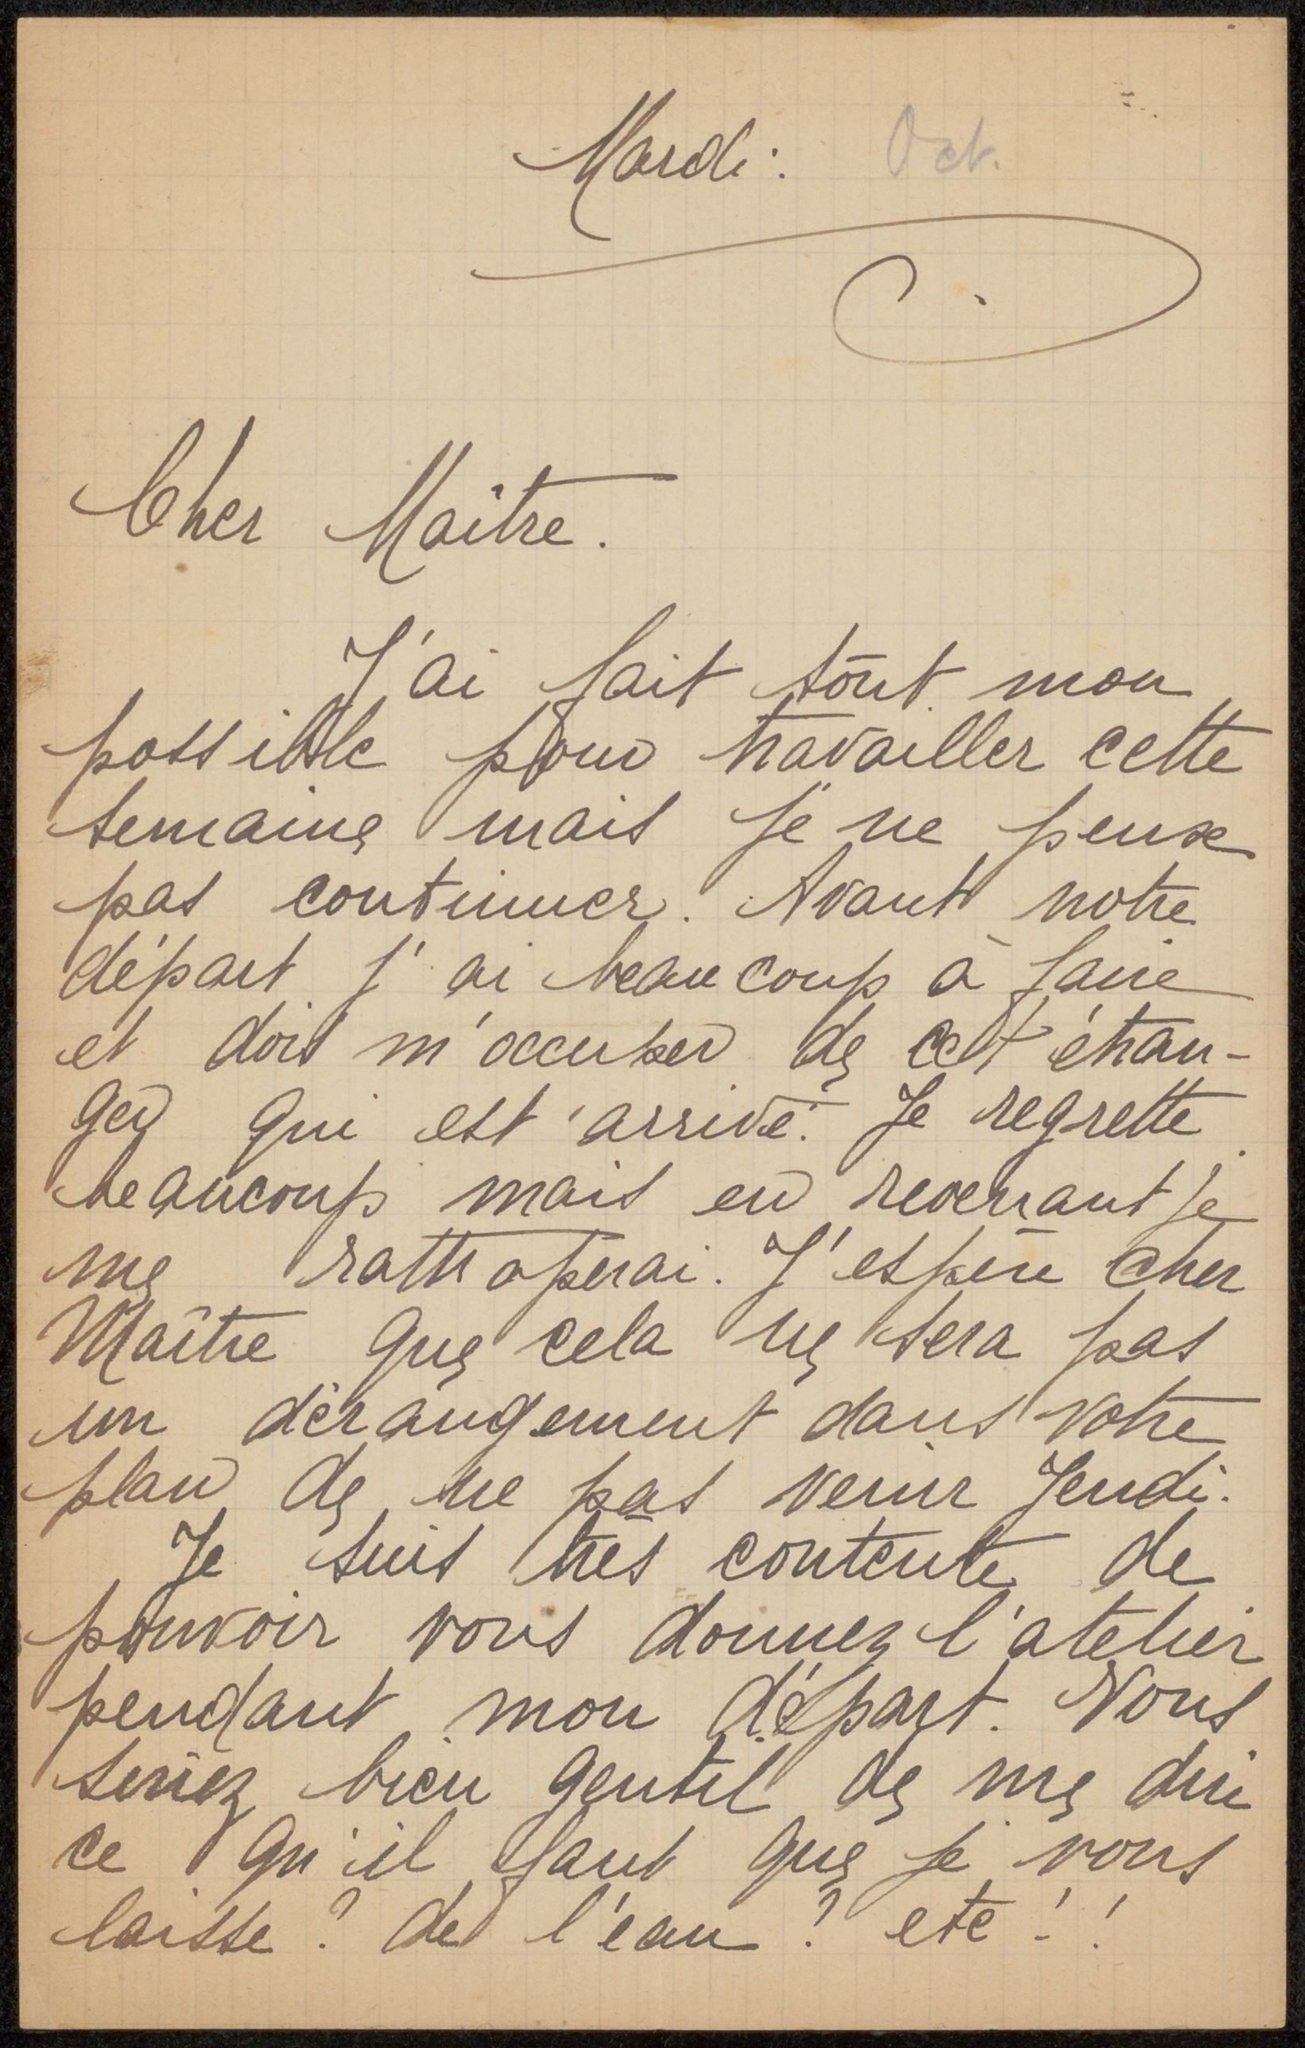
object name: letter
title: Brief aan Philip Zilcken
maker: rose imel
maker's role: draughtsman, painter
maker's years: 1901-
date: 1911-1930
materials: ink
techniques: pen, writing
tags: painter, draughtsman, philip zilcken, workshop, studio of the artist (in general)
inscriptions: collector's mark: ‘RPK’